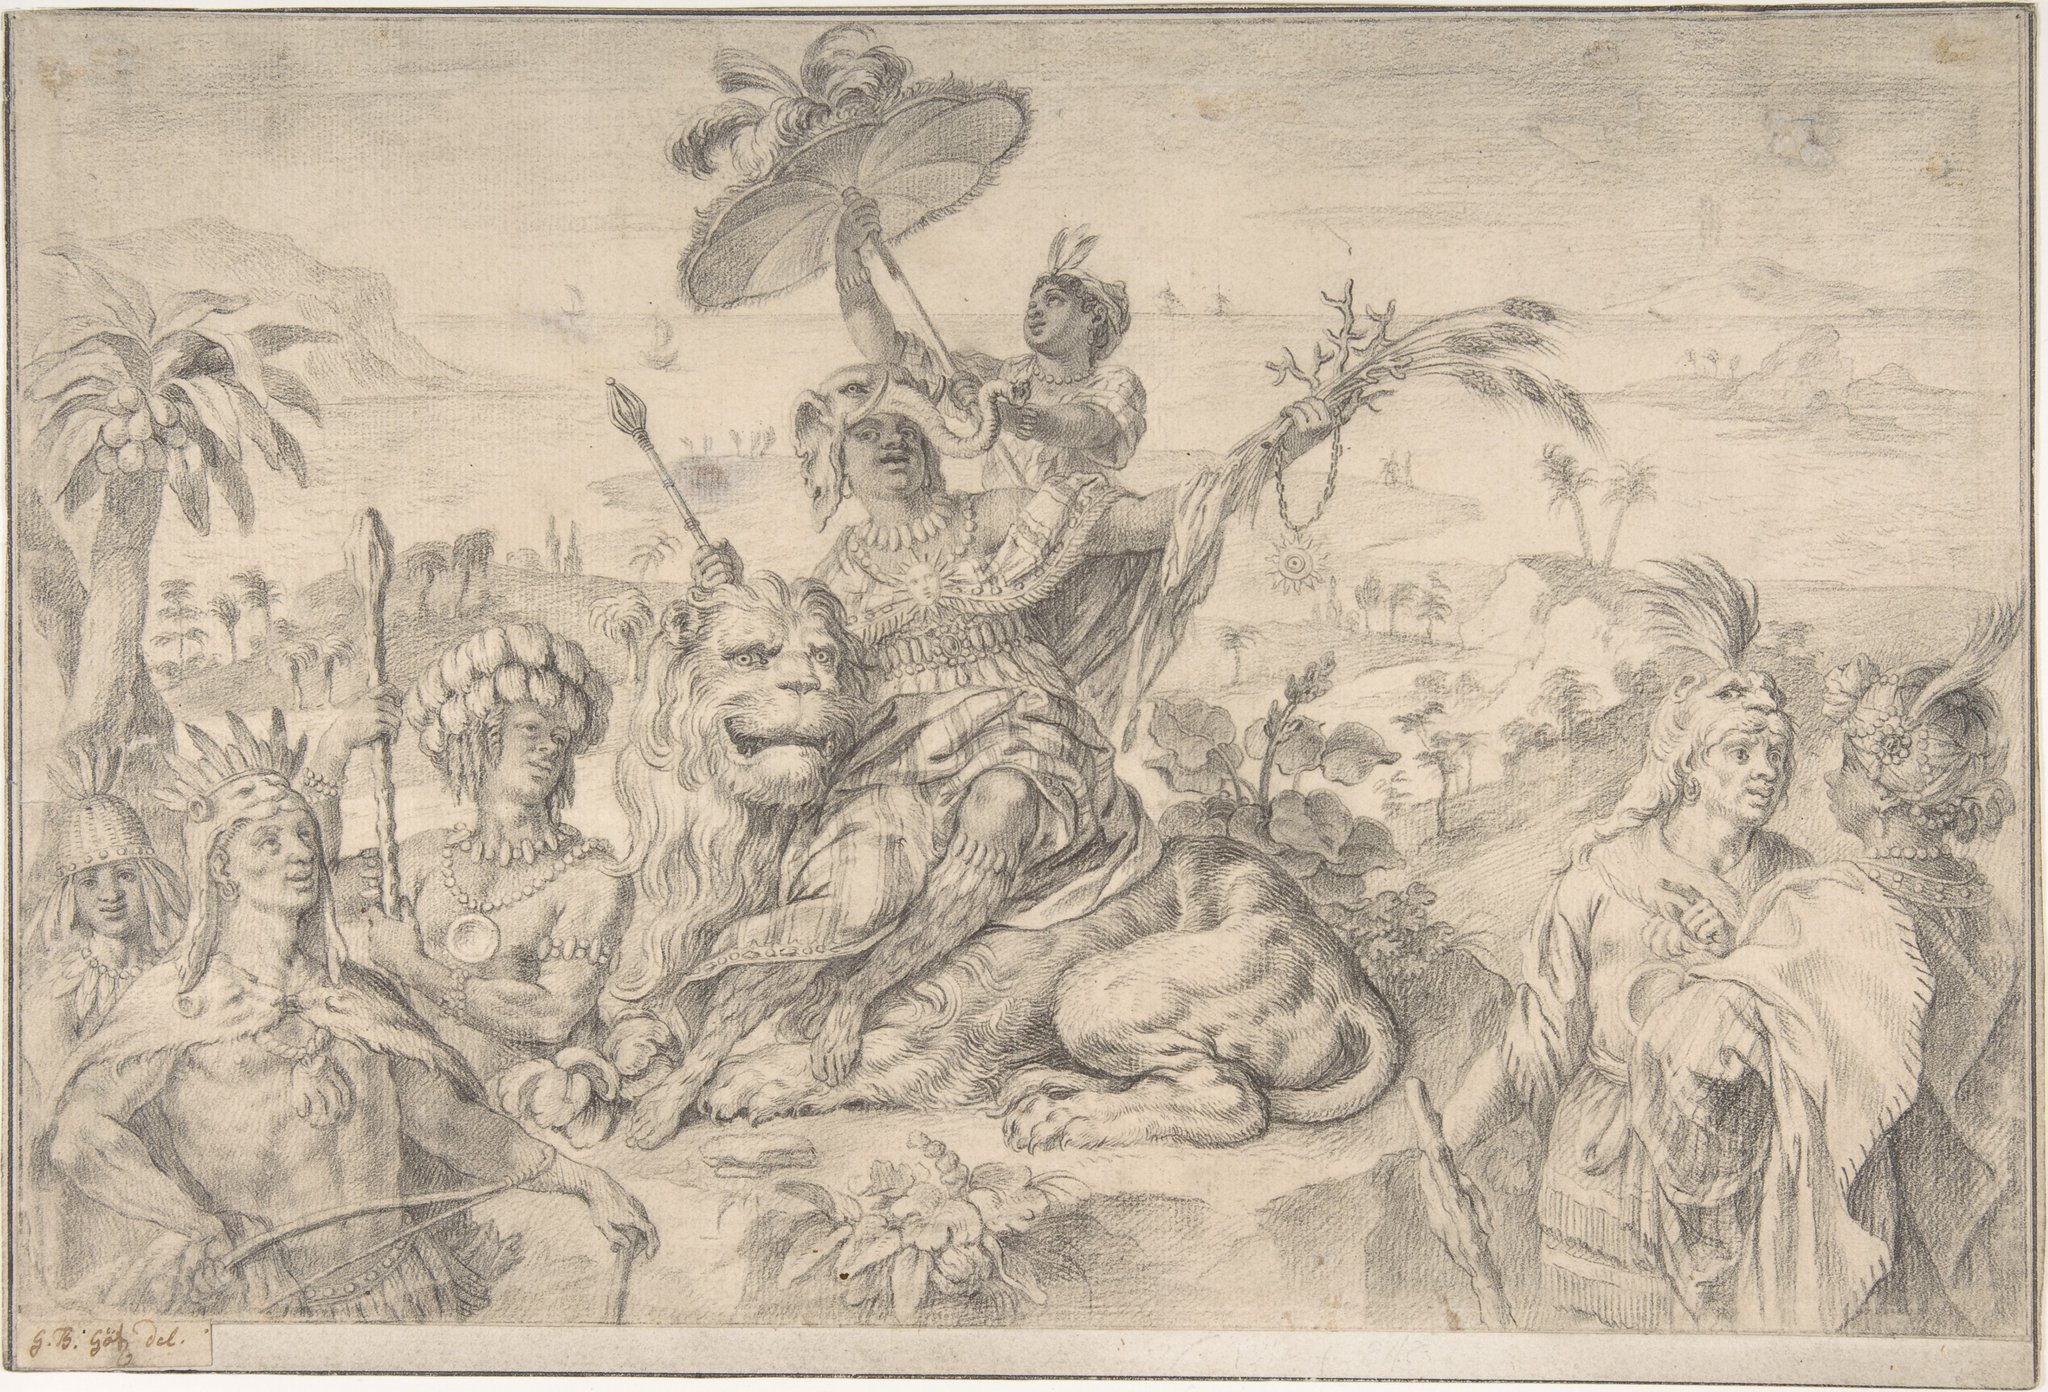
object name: drawing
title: Allegory of Africa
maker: gottfried bernhard goetz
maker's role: artist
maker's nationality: german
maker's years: 1708-1774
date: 1728-1774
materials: chalk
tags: spears,men,lions,trees